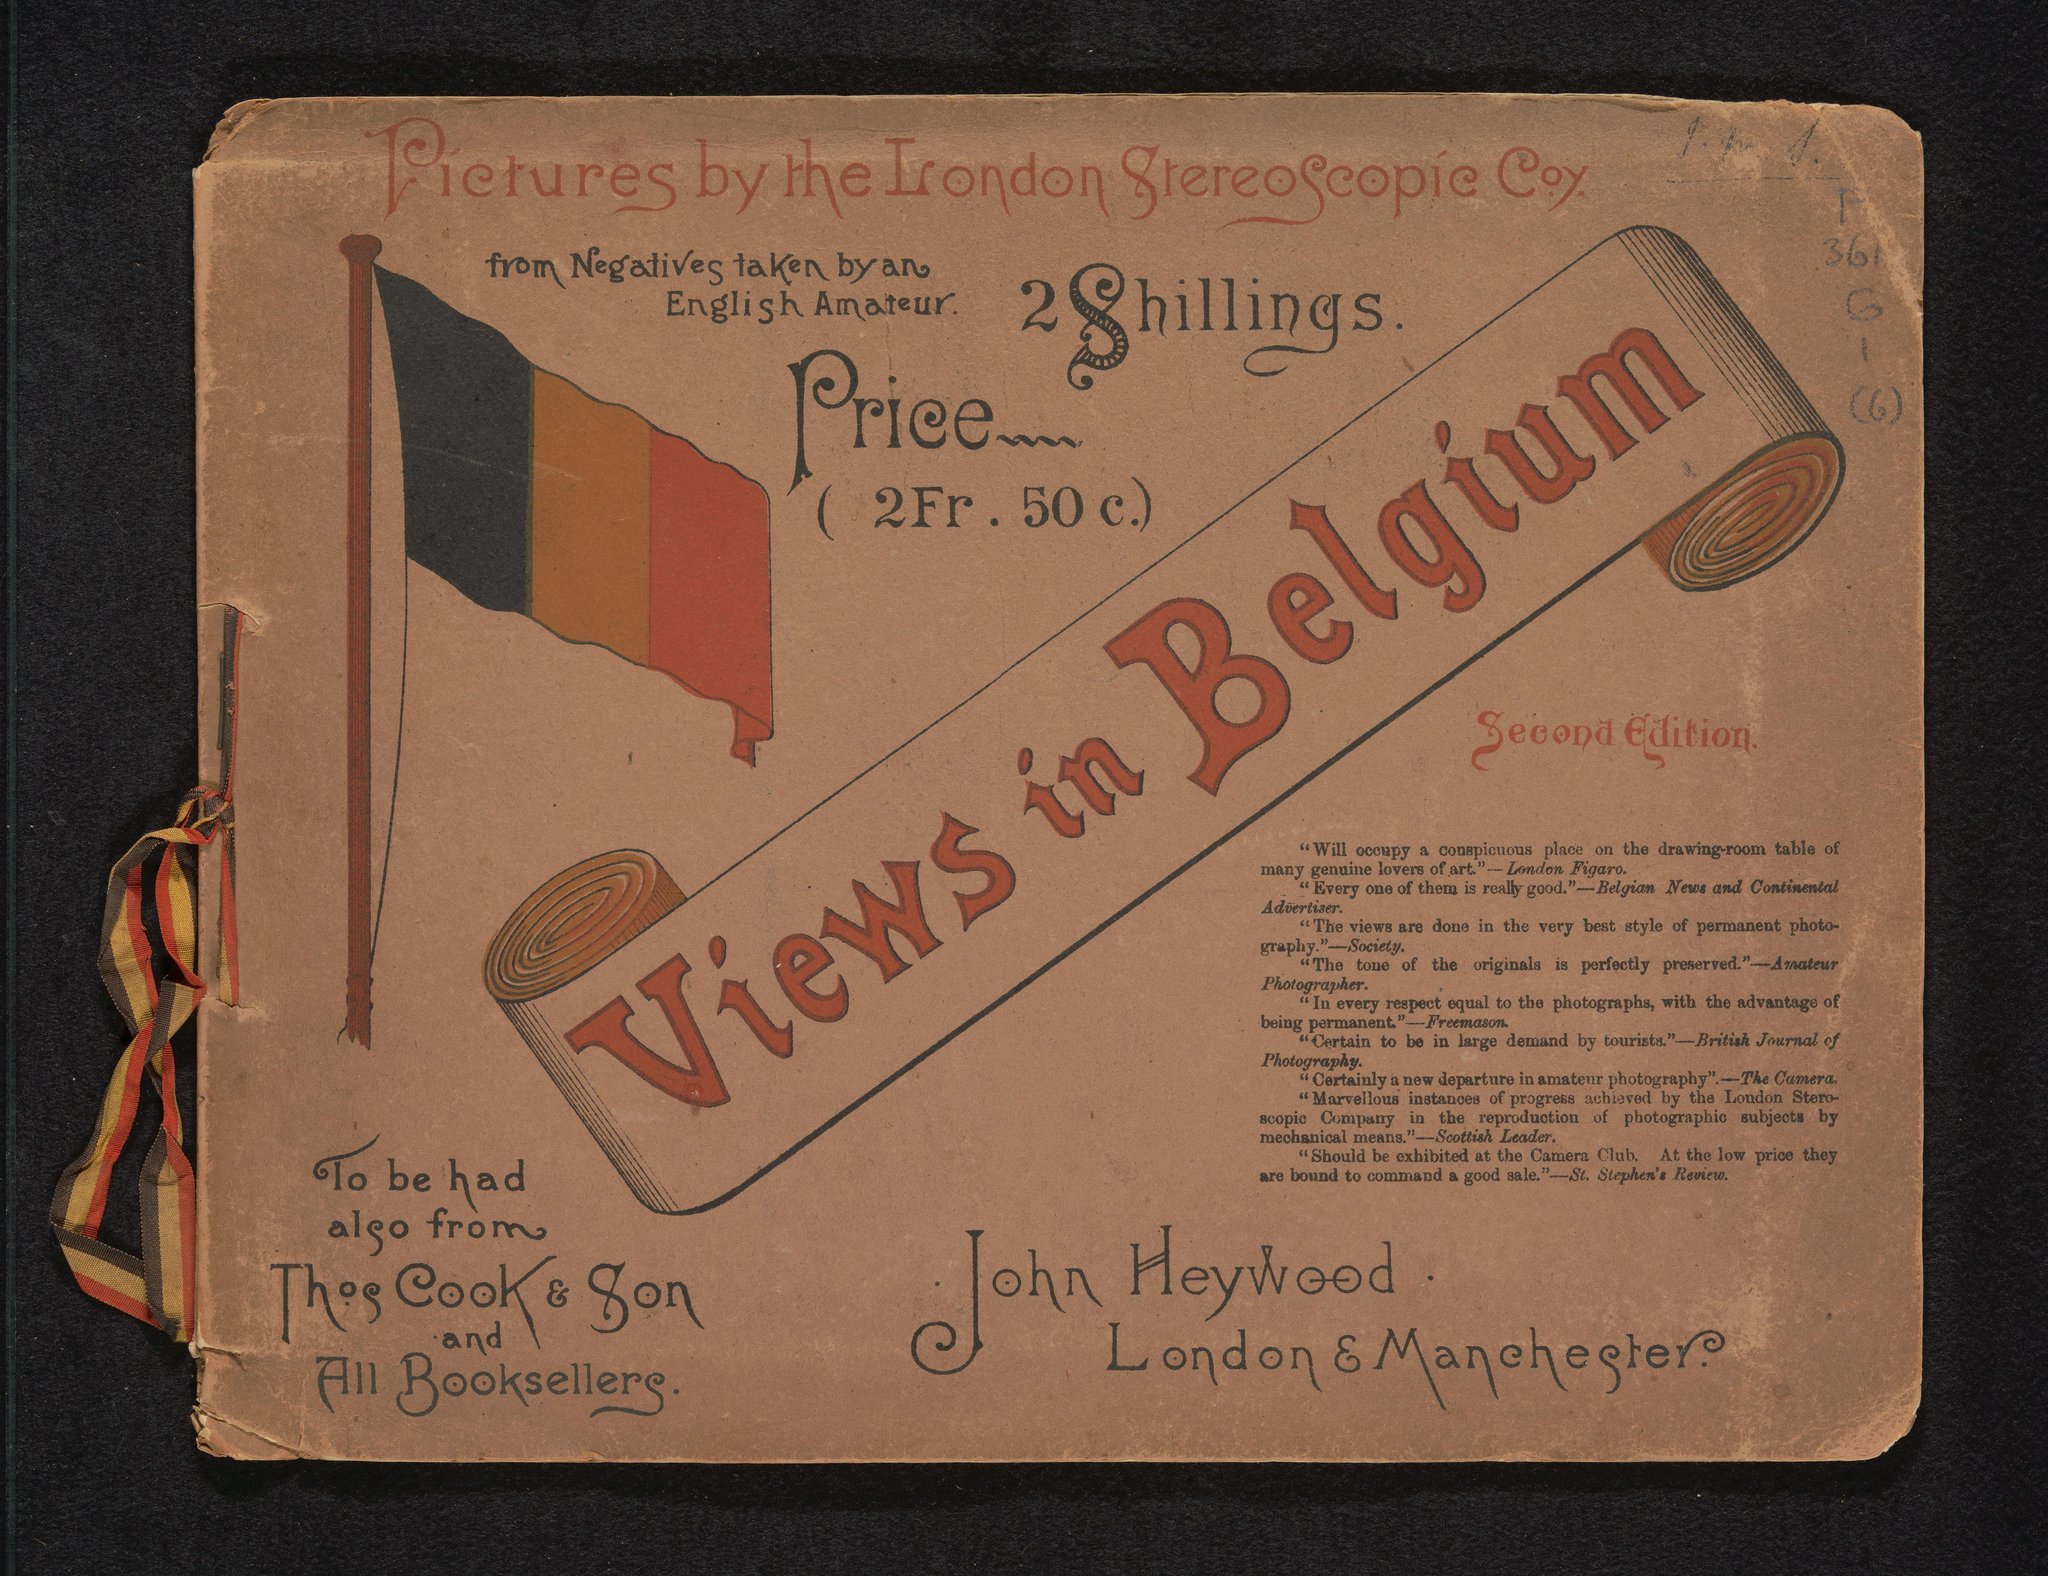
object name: book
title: Views in Belgium / pictures by the London Stereoscopic Coy., from negatives taken by an English amateur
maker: john heywood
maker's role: printer, publisher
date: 1890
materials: cardboard, paper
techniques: photograph, printing, engraving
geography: london